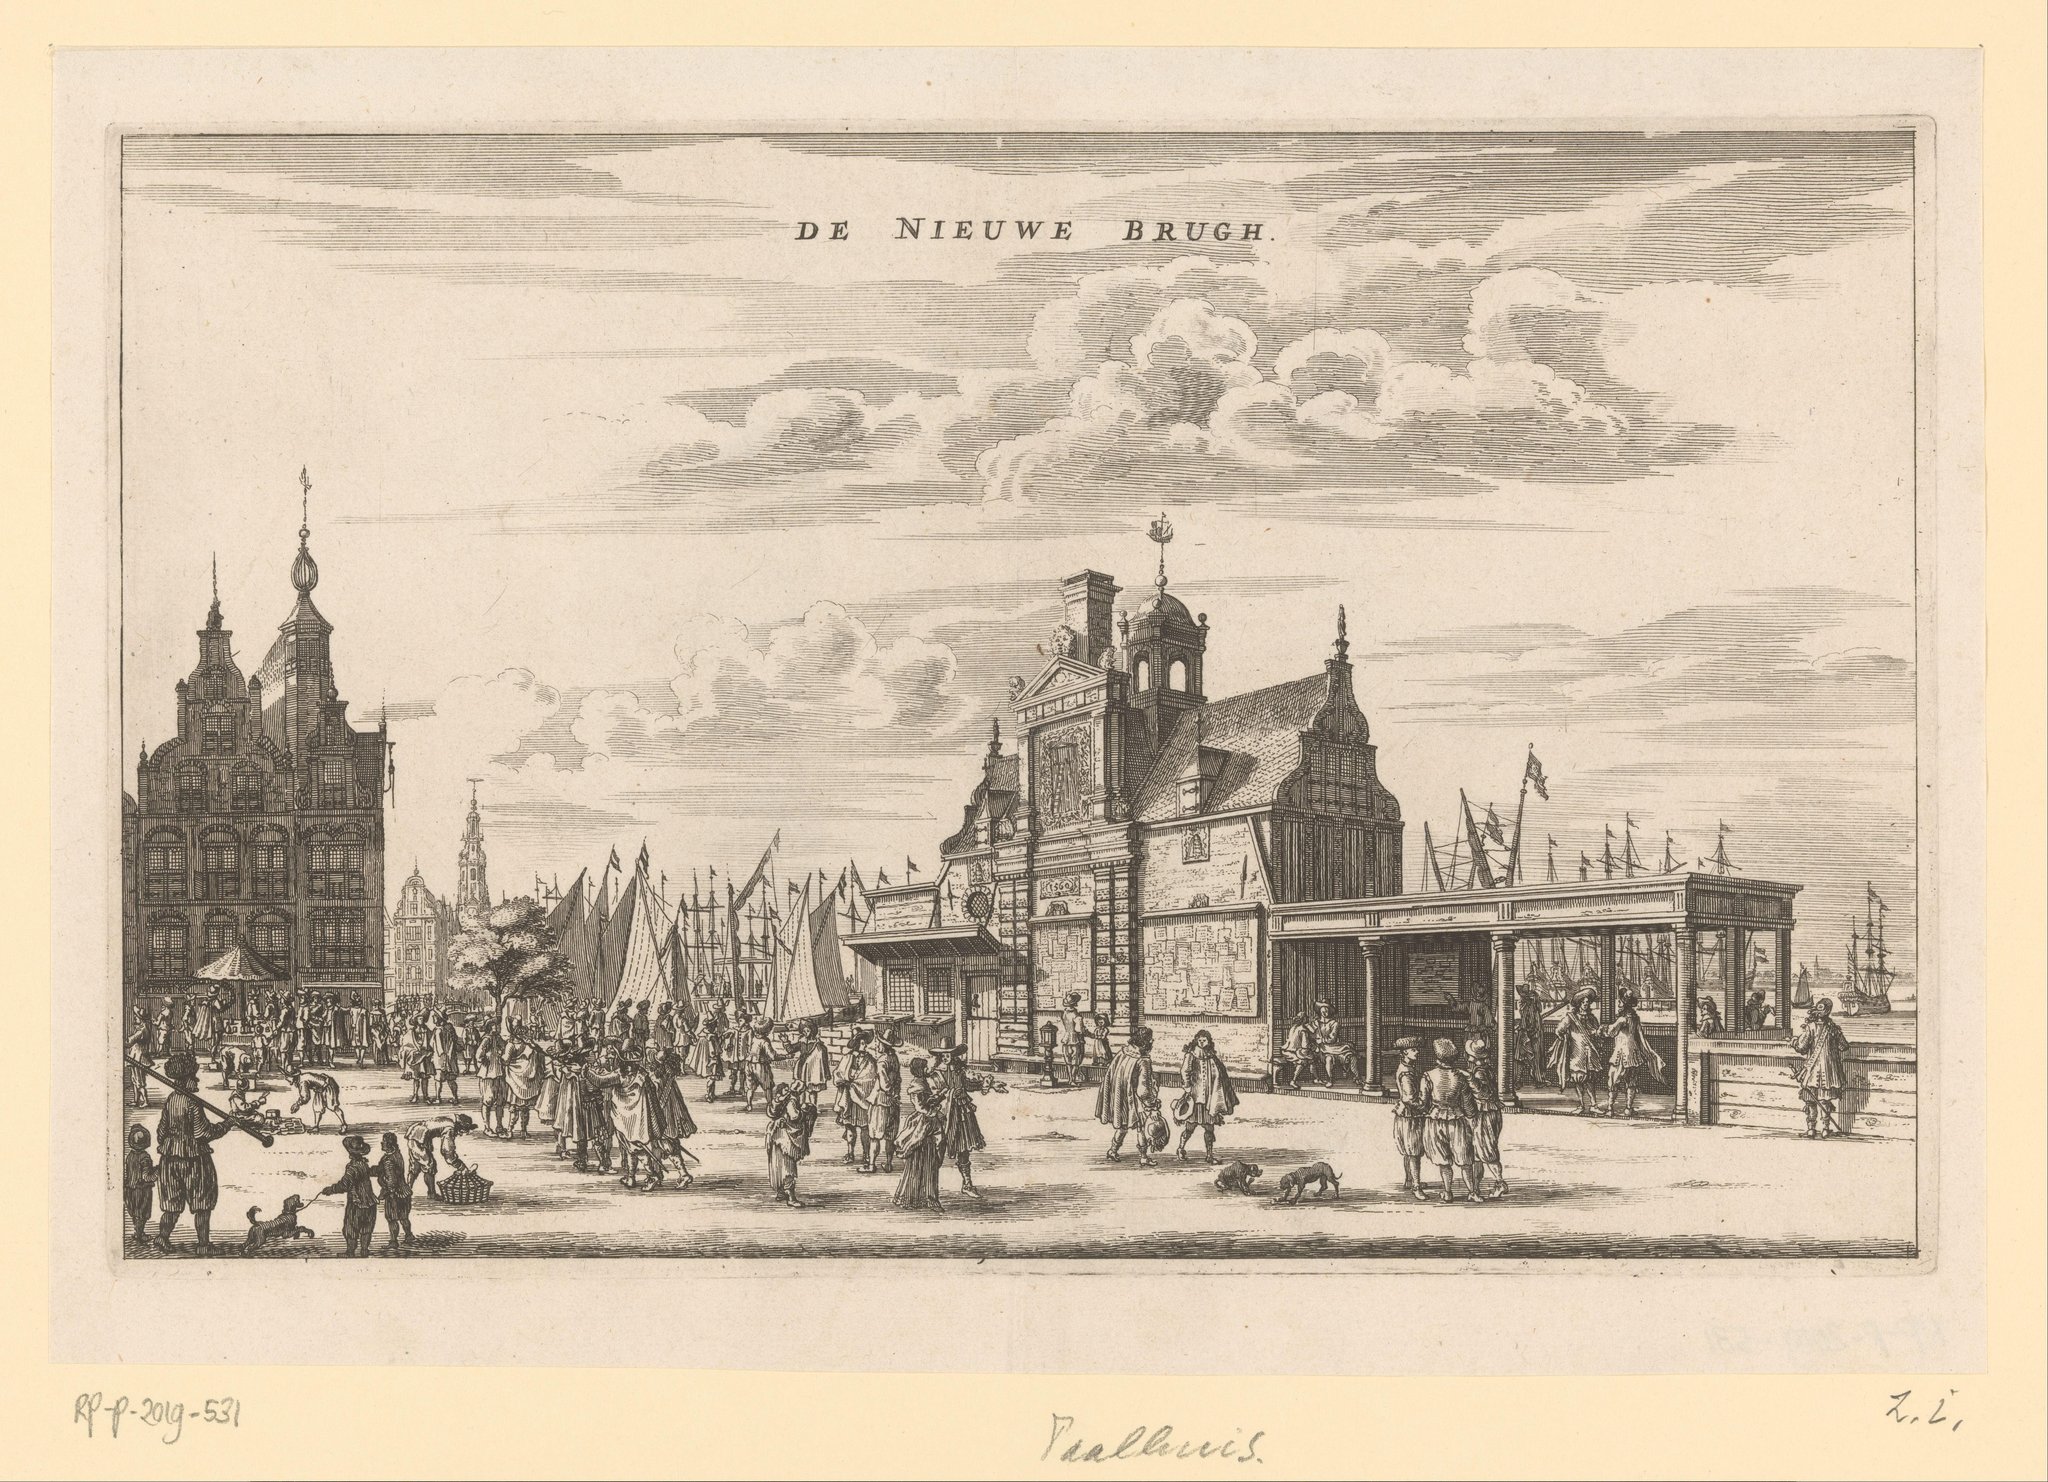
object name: print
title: De Nieuwe Brugh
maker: jacob van meurs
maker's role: draughtsman, print maker, publisher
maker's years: 1619-1680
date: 1663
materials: paper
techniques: engraving, etching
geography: amsterdam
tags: post-office, street (+ city(-scape) with figures, staffage)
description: Prent uit: Dapper, Olfert. Historische beschryving der stadt Amsterdam: waer in de voornaemste geschiedenissen (na een kort verhael van gansch Hollant en d'omleggende dorpen (…). Amsterdam: Jacob van Meurs, 1663. Latere staat van prent heeft een toegevoegde Franse titel.